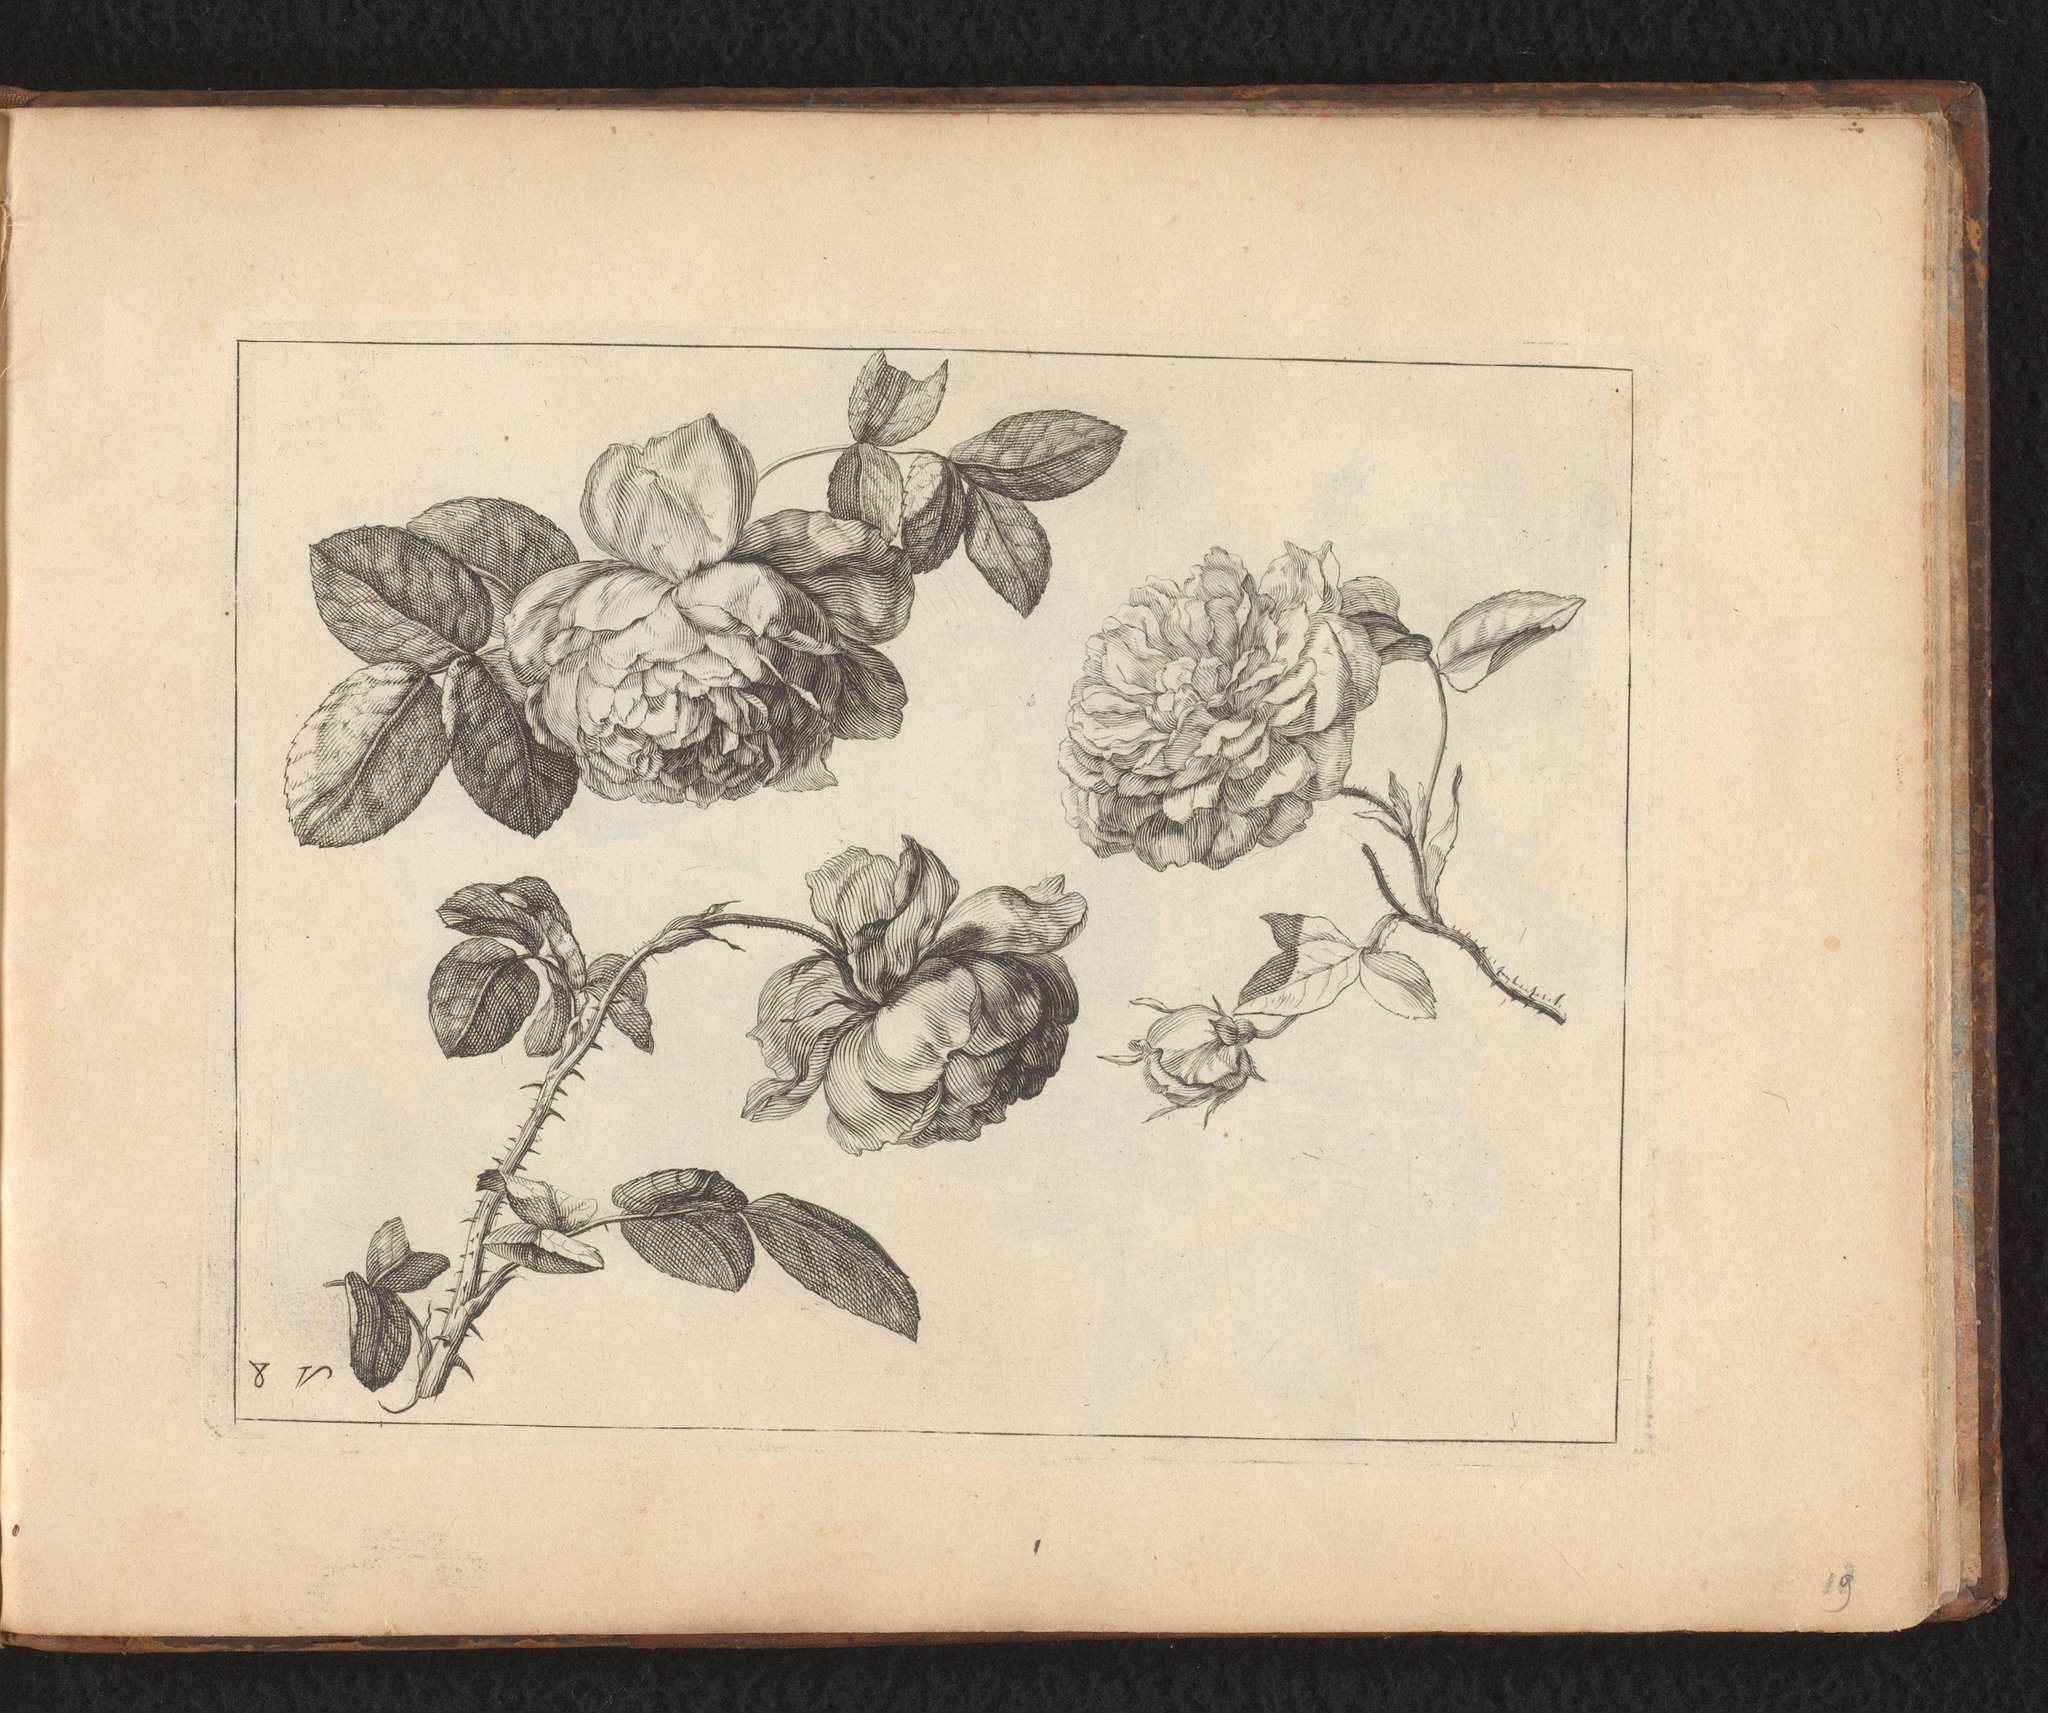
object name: print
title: Verzameling van bloemen, elke soort in verschillende aspecten weergegeven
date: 1650-1676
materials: paper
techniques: engraving, etching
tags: flowers: rose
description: Deze prent maakt deel uit van een album.